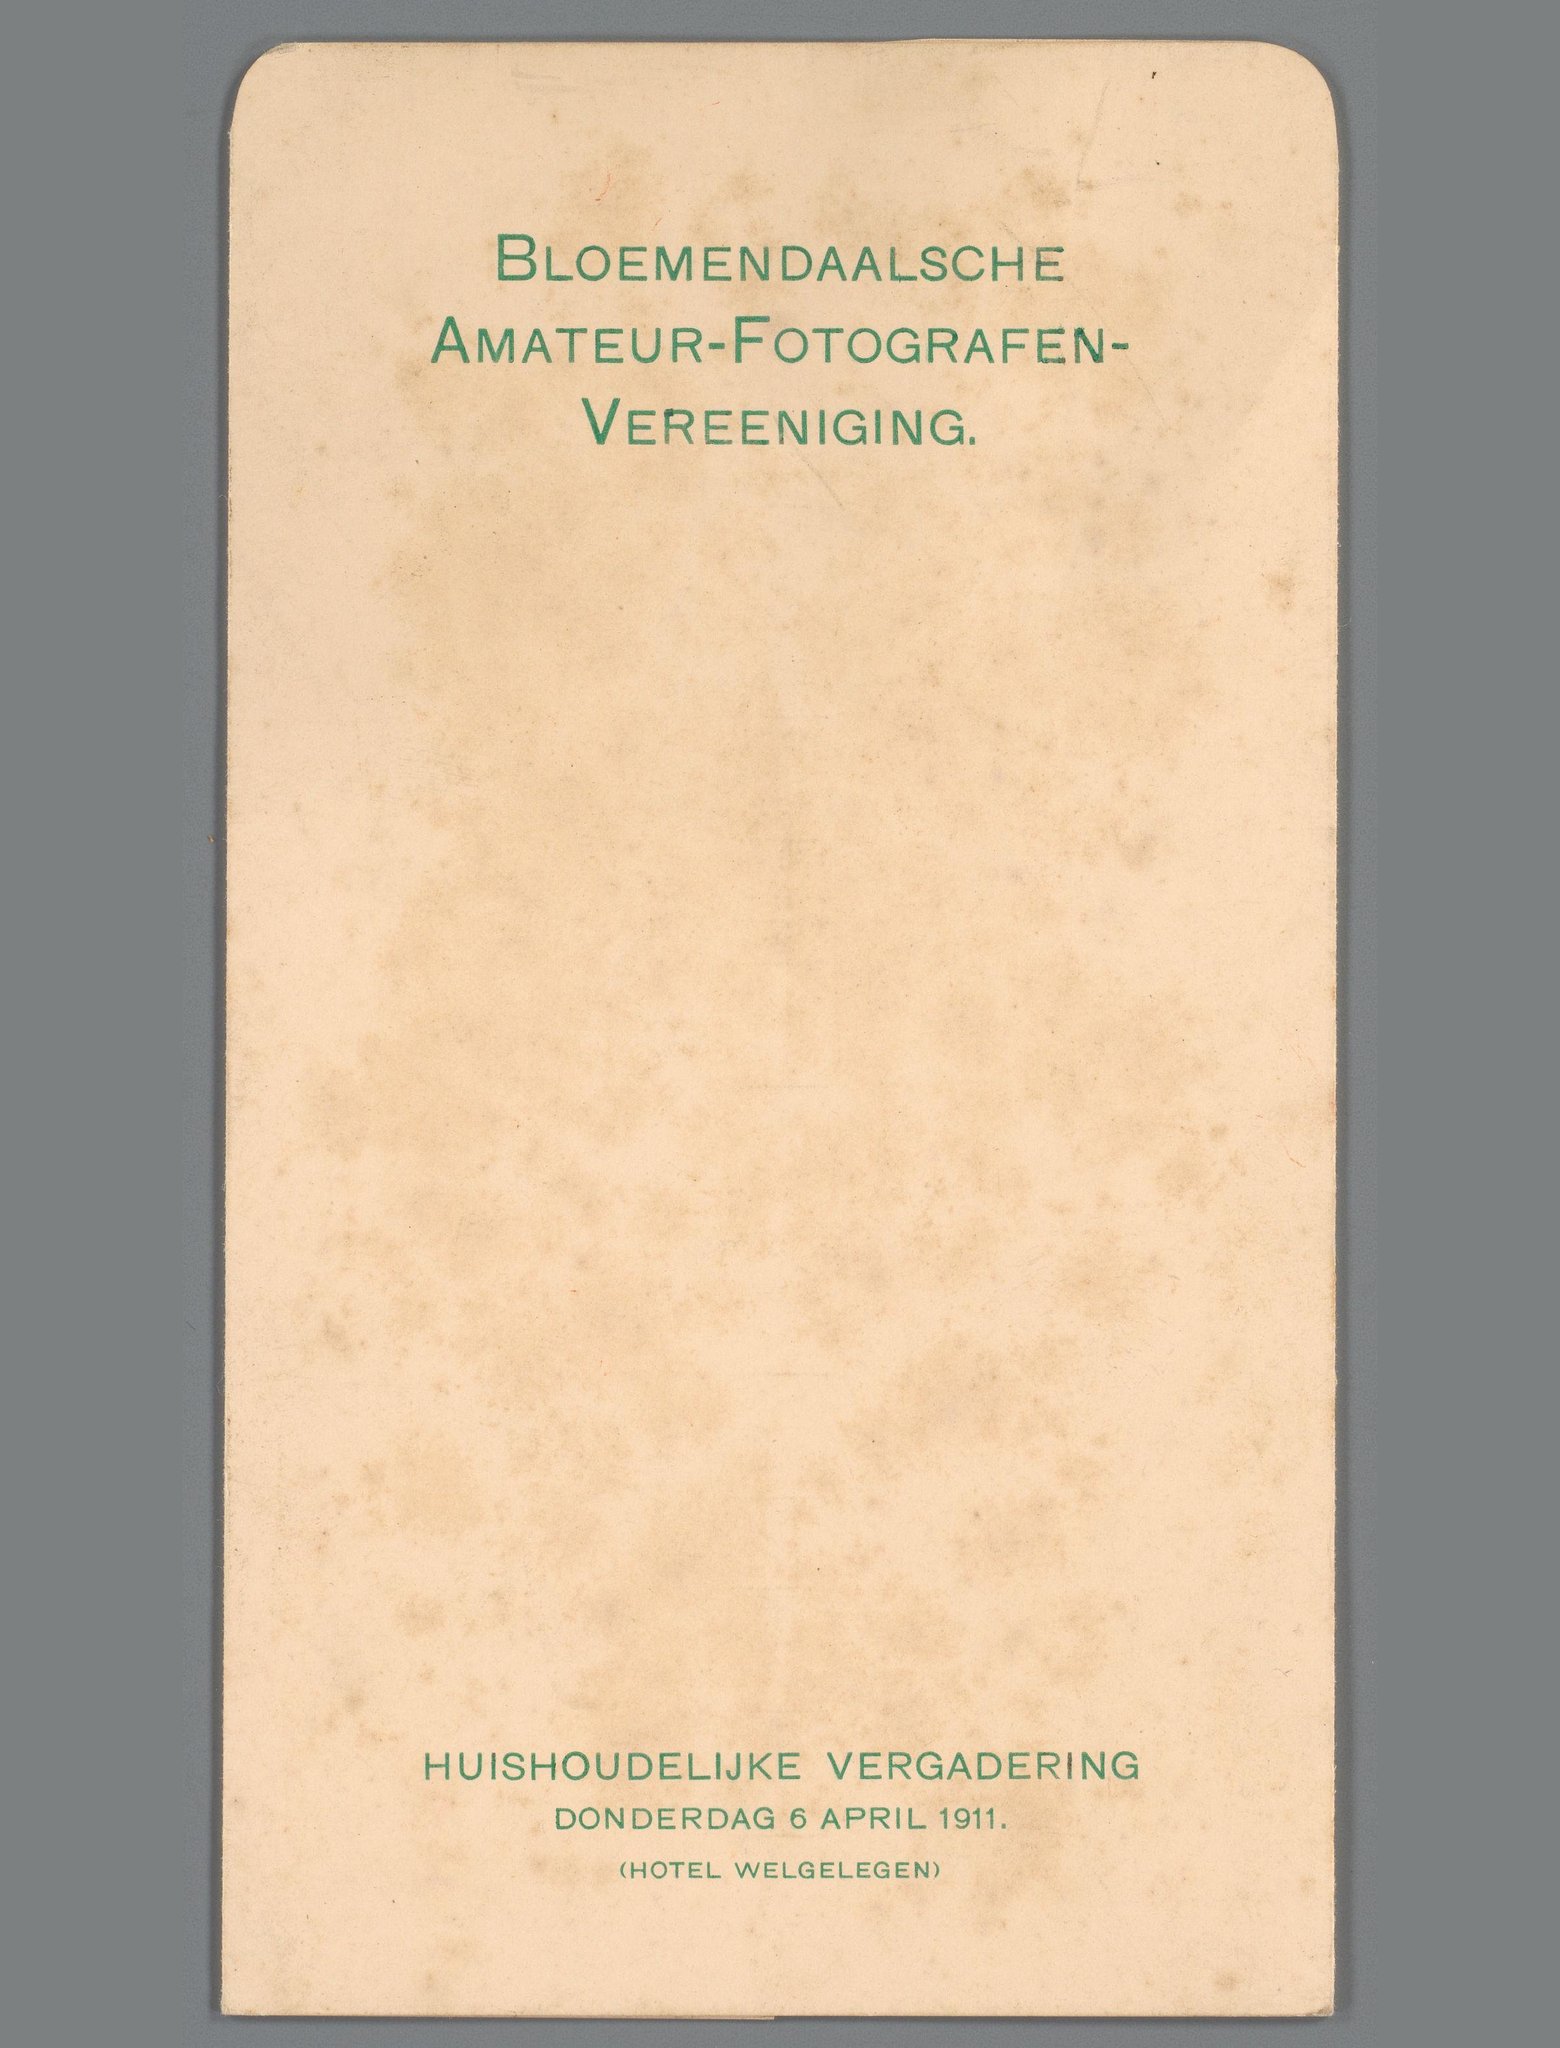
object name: tekst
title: Programma voor de Huishoudelijke vergadering van de Bloemendaalsche Amateur-Fotografen Vereeniging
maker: Anonymous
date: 1911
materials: cardboard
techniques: letterpress printing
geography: bloemendaal